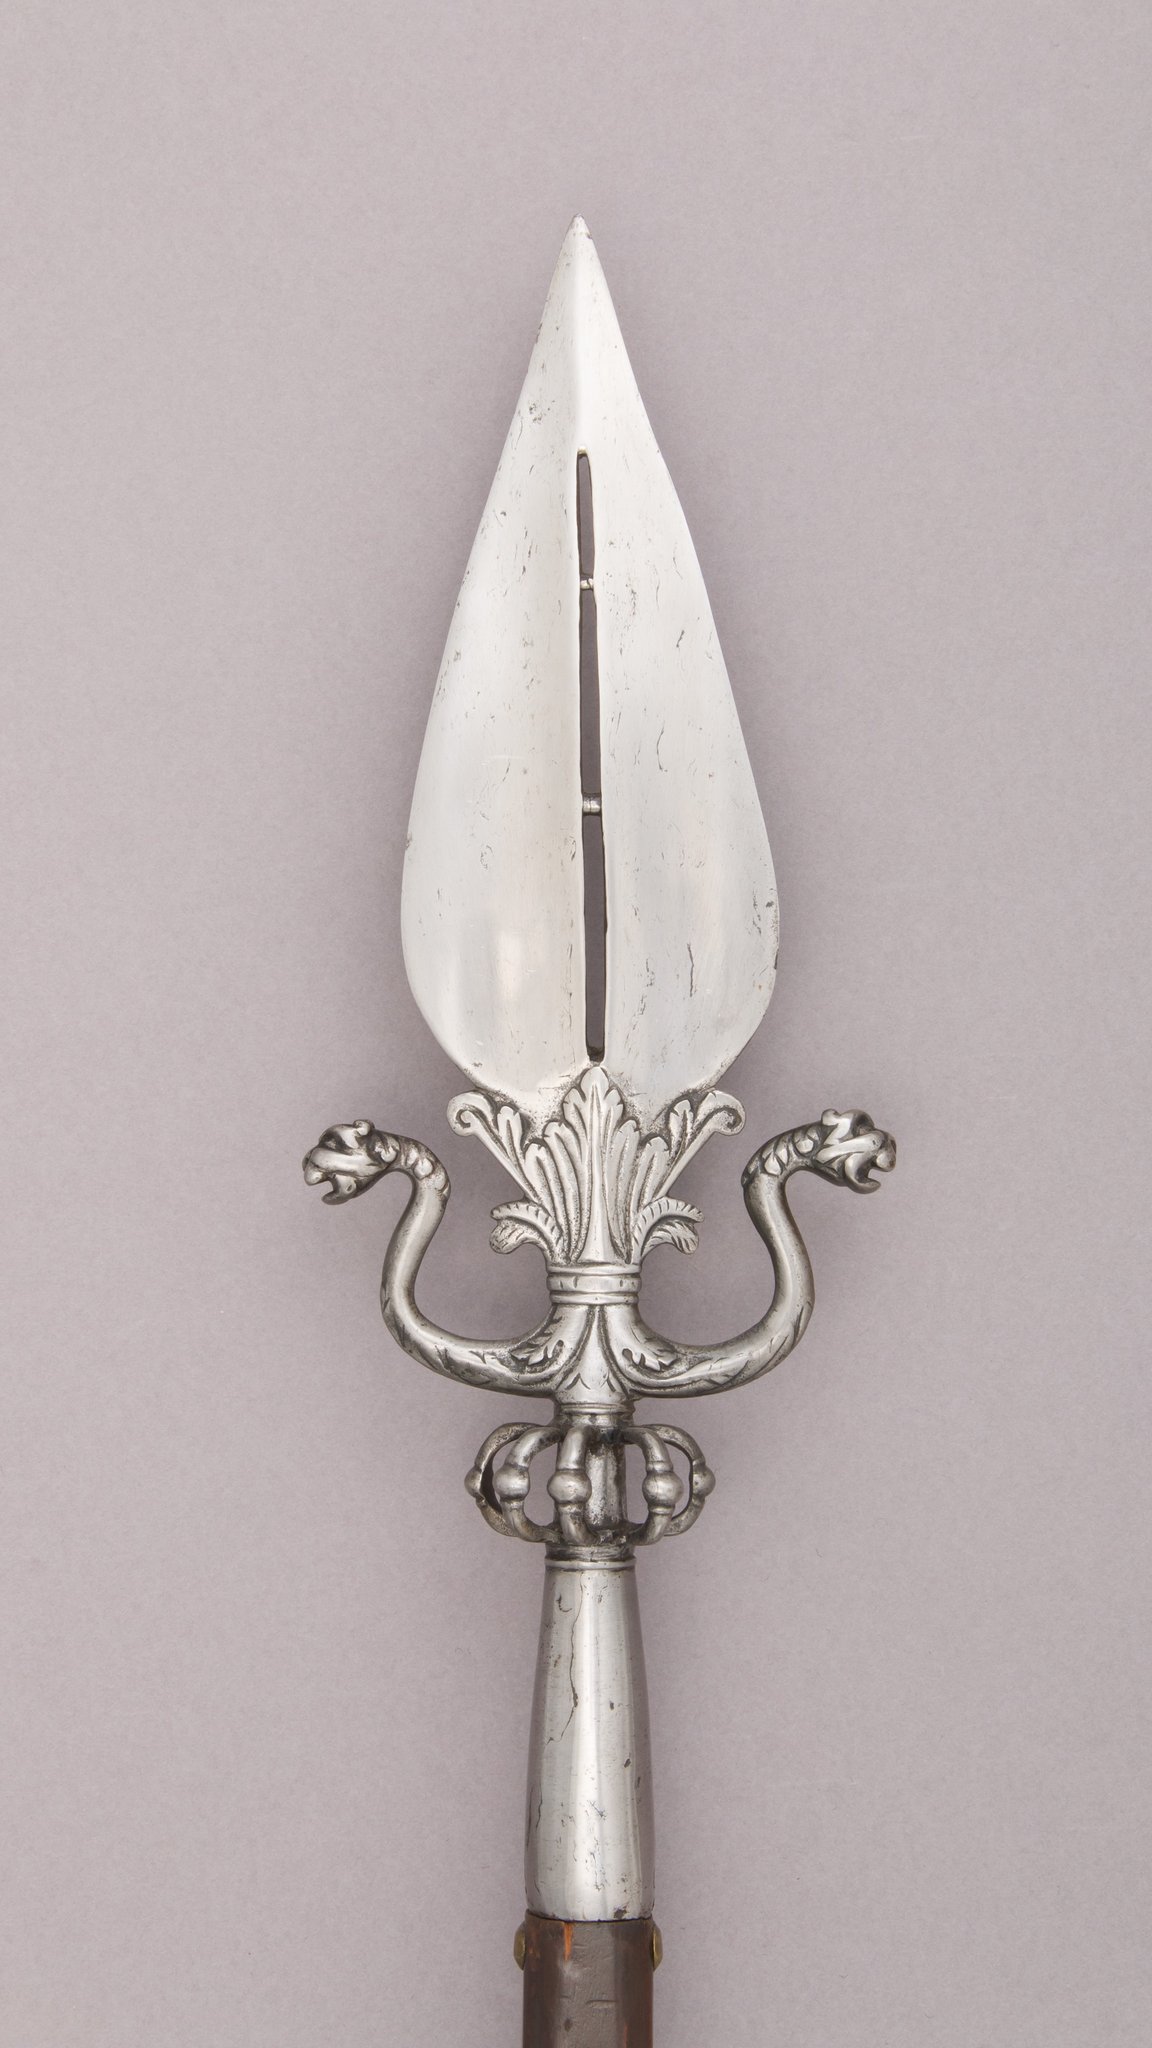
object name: lance linstock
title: Lance-Linstock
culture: italian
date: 1601-1700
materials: brass, iron, steel, wood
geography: italy